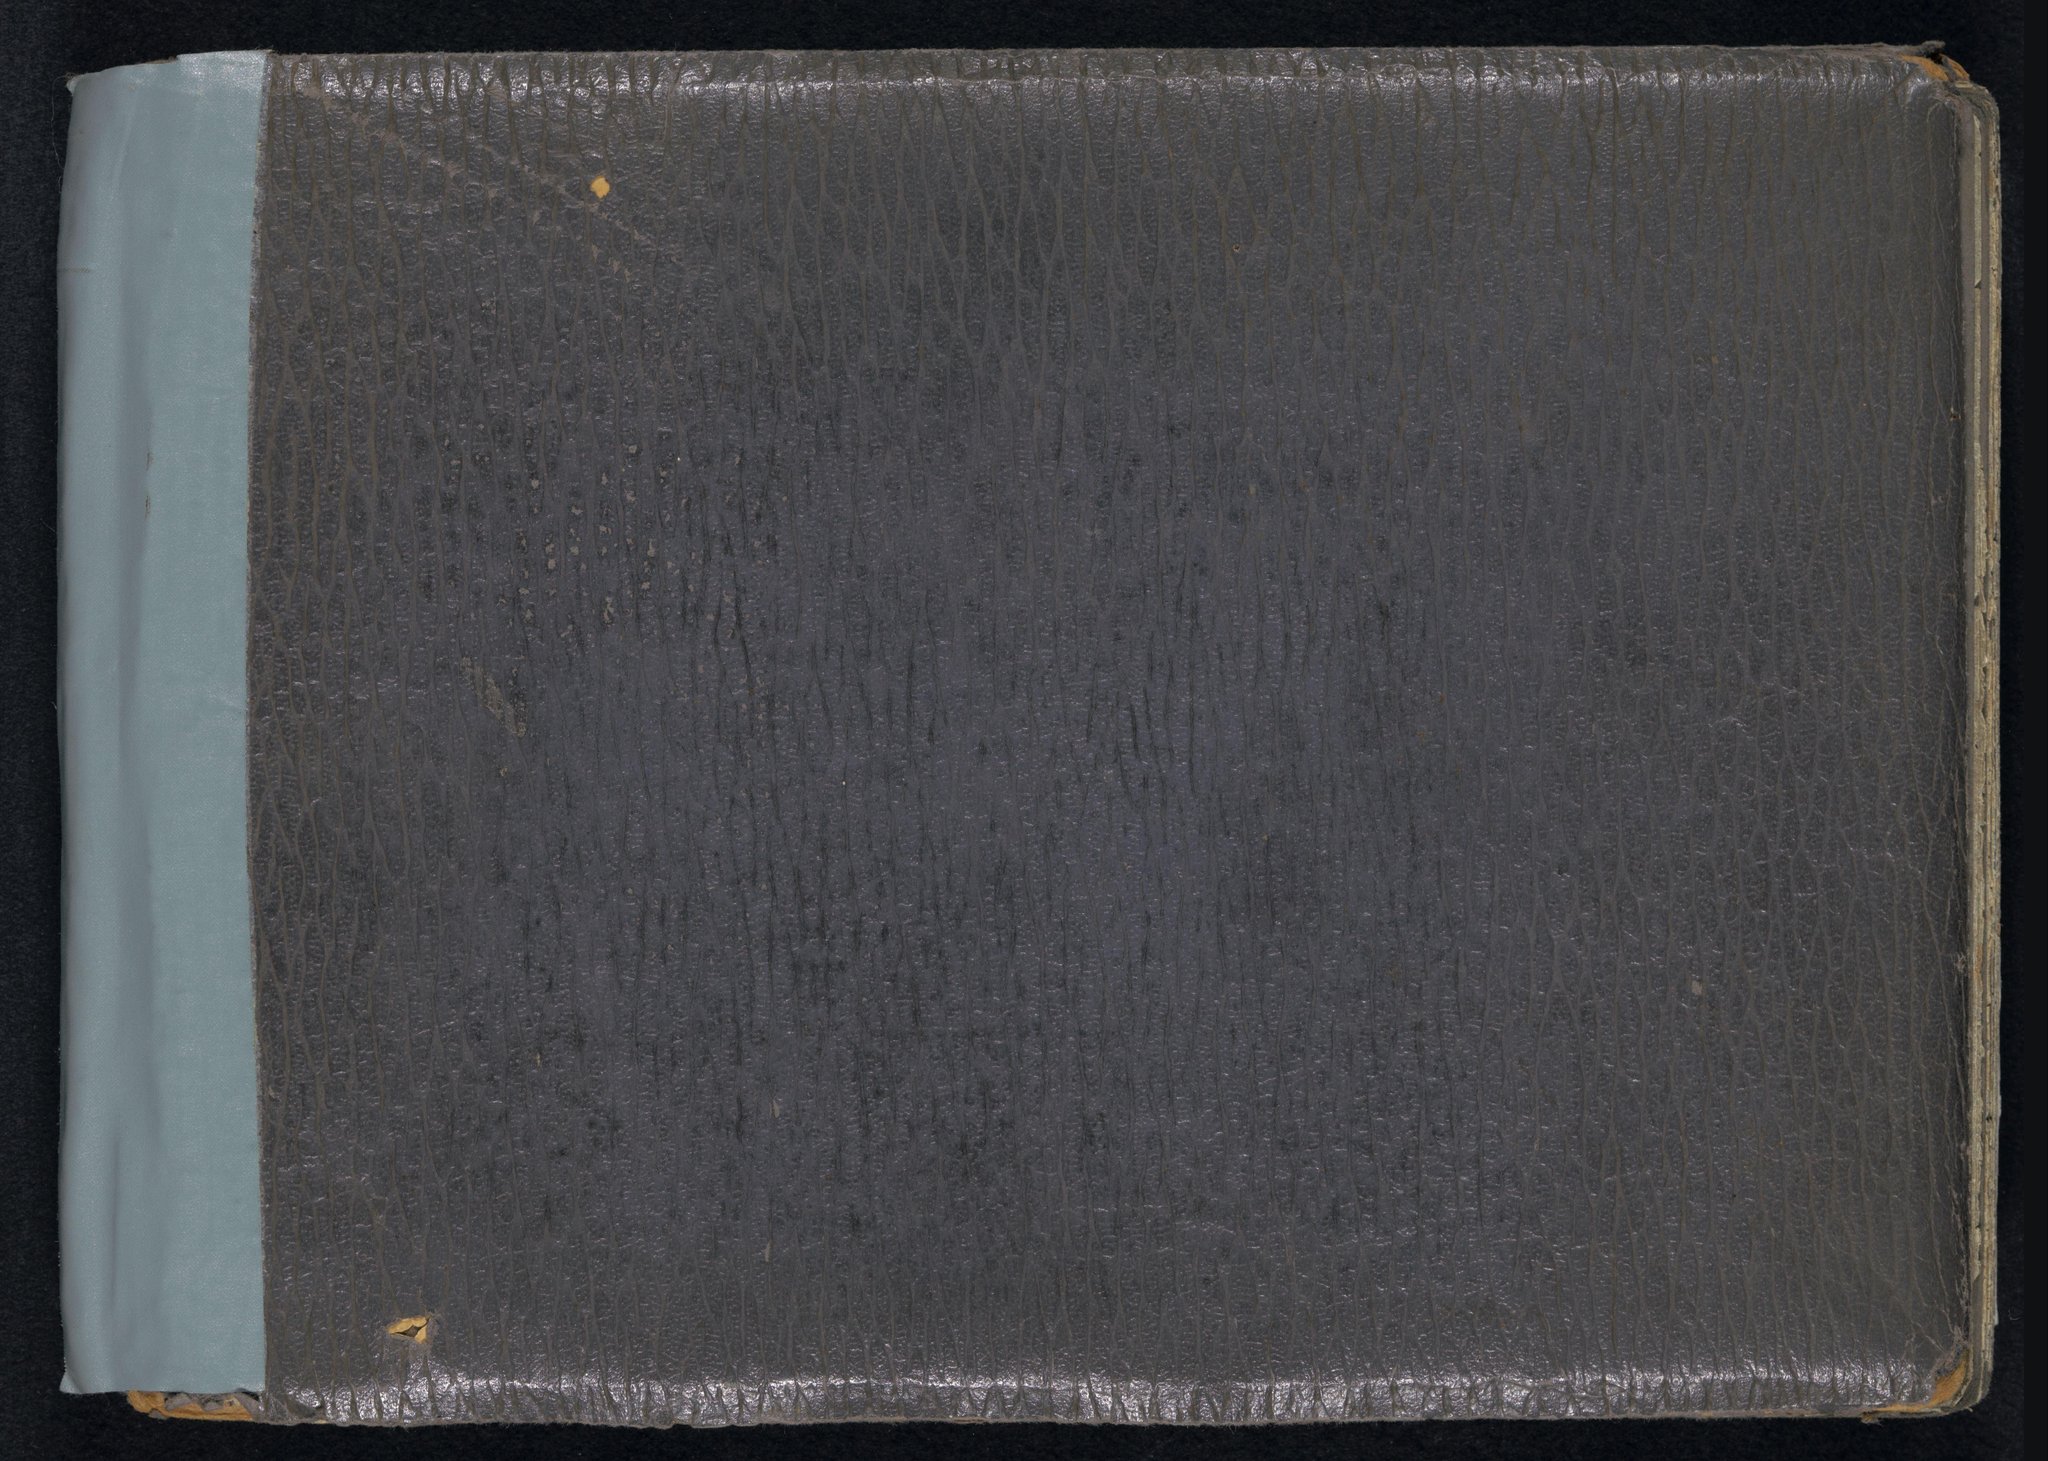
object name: scrapbook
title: Zur Erinnerung an meine Dienstzeit v. 1.4.1941-28.9.1945 Heinrich Clausen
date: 1930-1990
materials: cardboard, paper, photographic support, plastic, tape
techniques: gelatin silver print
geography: netherlands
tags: germany, rotterdam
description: Fotoalbum van de Kriegsmarine in de periode 1941-1945. Omslag van grijs geplastificeerd materiaal. Binnenwerk bestaande uit 20 bladen waarop 162 foto's. Foto's van diensttijd in Vlaardingen en Rotterdam en familieleven in Duitsland na de oorlog. Op de binnenkant van de kaft een beschrijving van de diensttijd van april 1941 tot september 1945. Clausen diende op een Marineschip genaamd "Alders". Vanaf bladzijde 29 jeugdfoto's van school en Hitlerjugend. Met bladzijde 31 begint het naoorlogse deel. Op de laatste bladzijde twee foto's van jonge man en oudere man, rechtsonder is vermoedelijk Clausen bij een Trabant in 1990. Veel foto's met onderschriften in rode inkt.